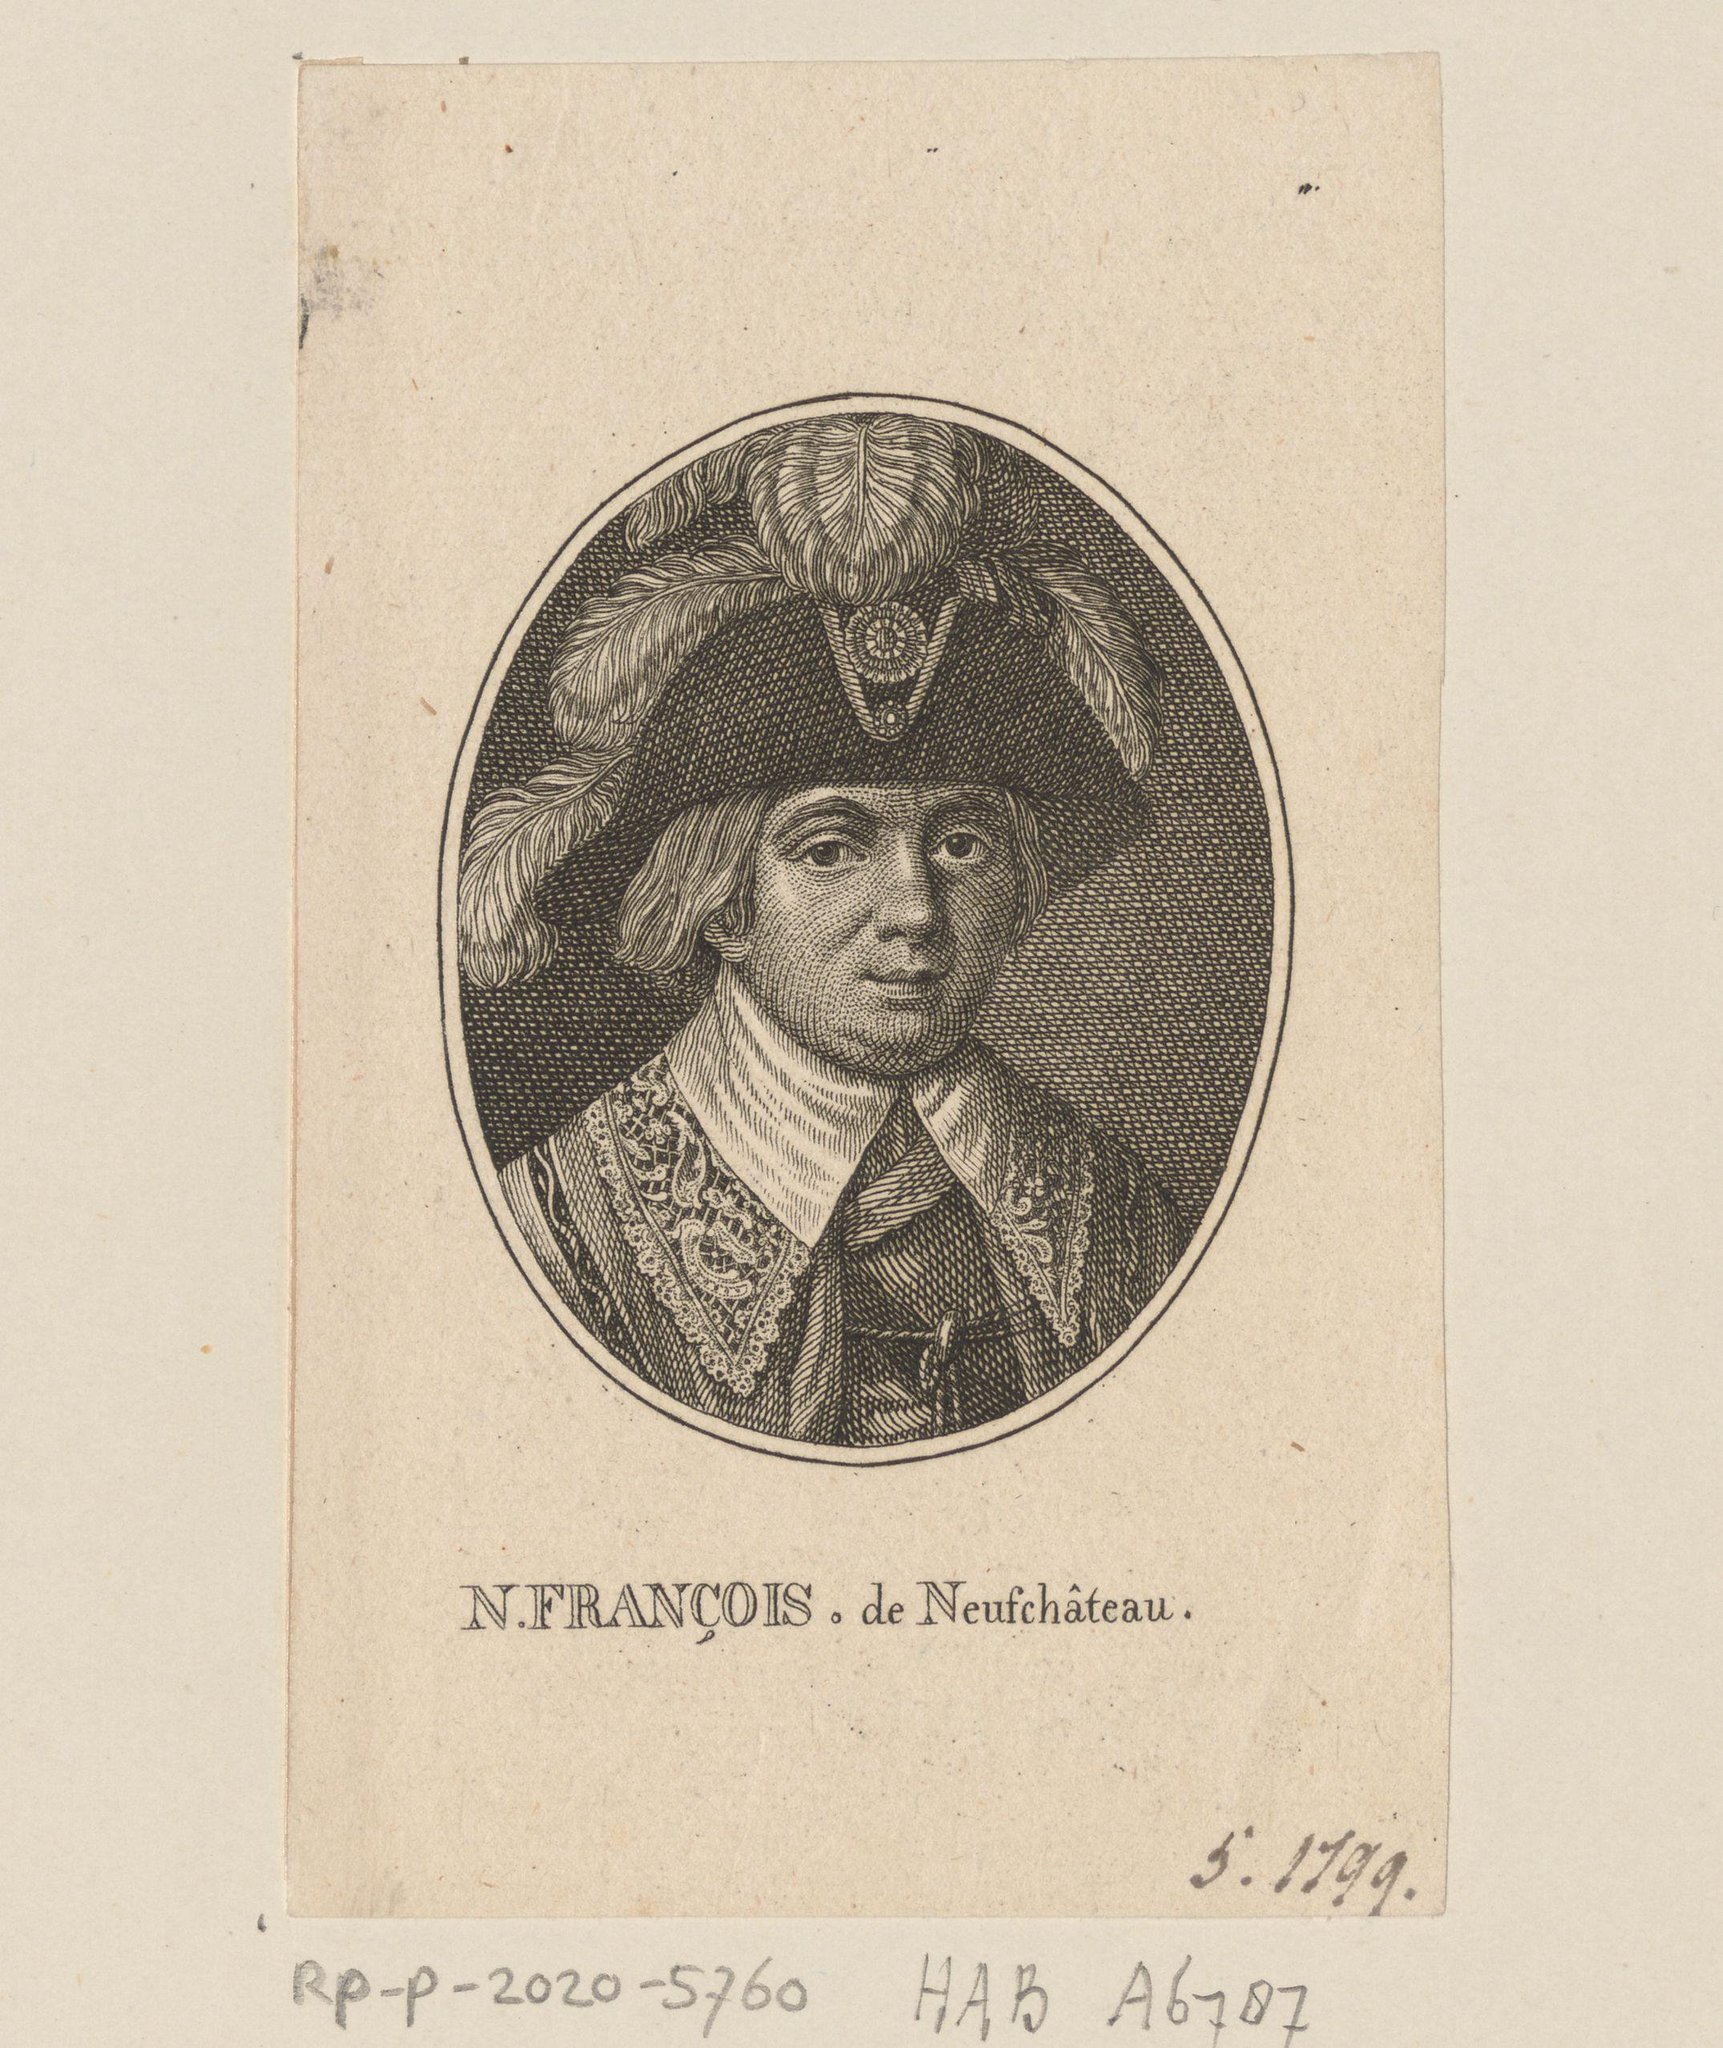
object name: print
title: Portret van Nicolas François de Neufchâteau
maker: Anonymous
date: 1799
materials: paper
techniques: etching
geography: germany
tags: historical persons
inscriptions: number: ‘5. 1799’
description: Prent waarschijnlijk uit: Revolutions-Almanach von 1799. Göttingen: Johann Christian Dieterich, 1799.